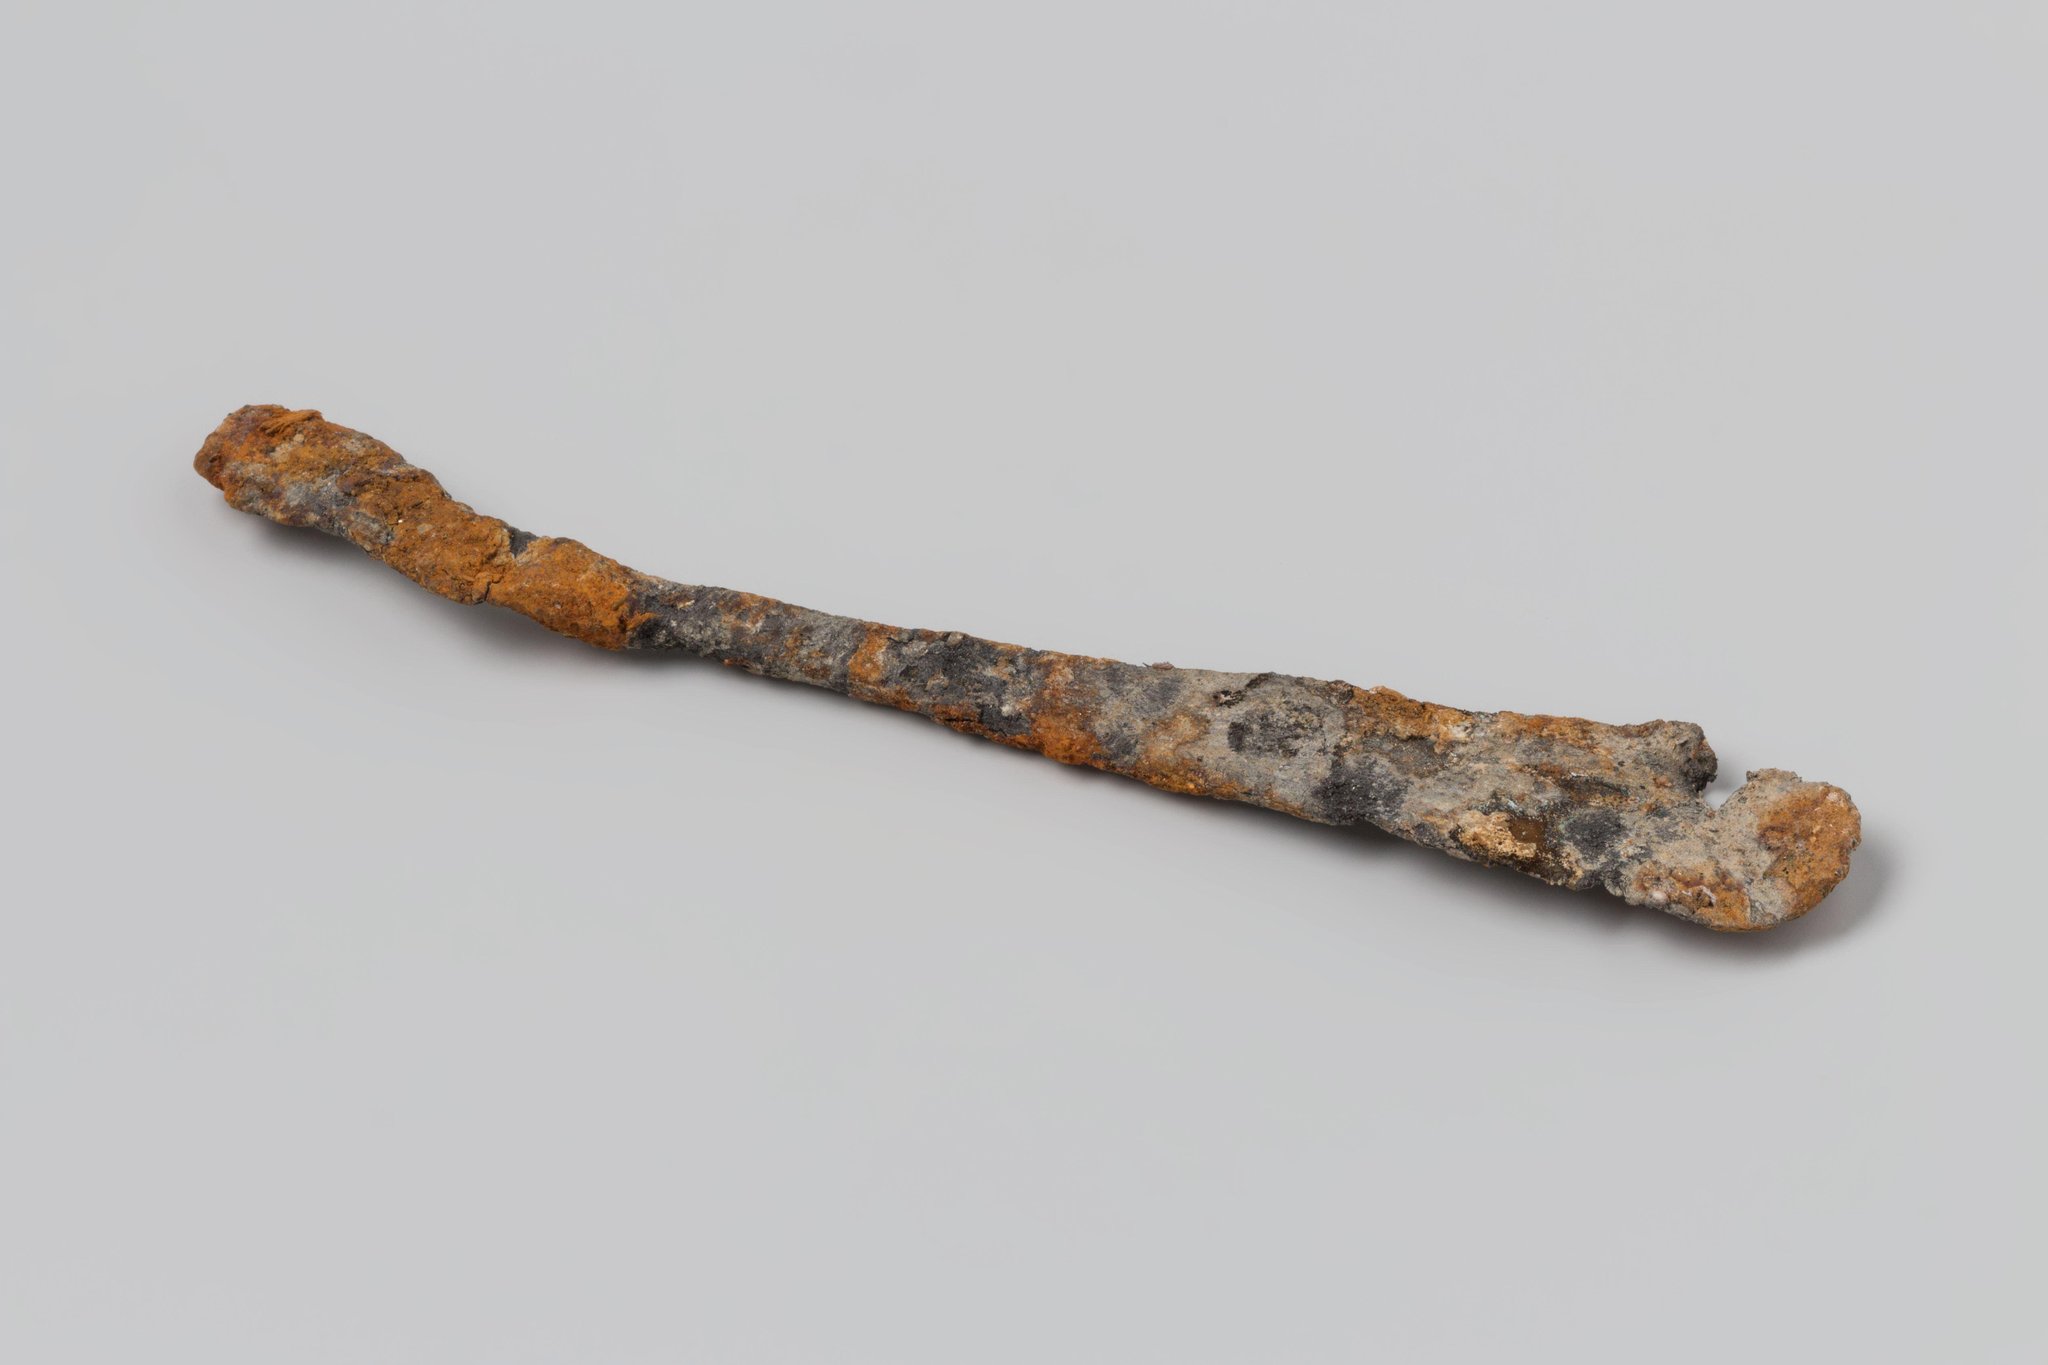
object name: fork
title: Fragment van een steel van een vork of lepel uit het wrak van de Oost-Indiëvaarder Hollandia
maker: Anonymous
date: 1700-1743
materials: tin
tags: verenigde oostindische compagnie, hollandia (schip), annet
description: Fragments: stem of fork or spoon; fragm, id. NG 1980-27H67.